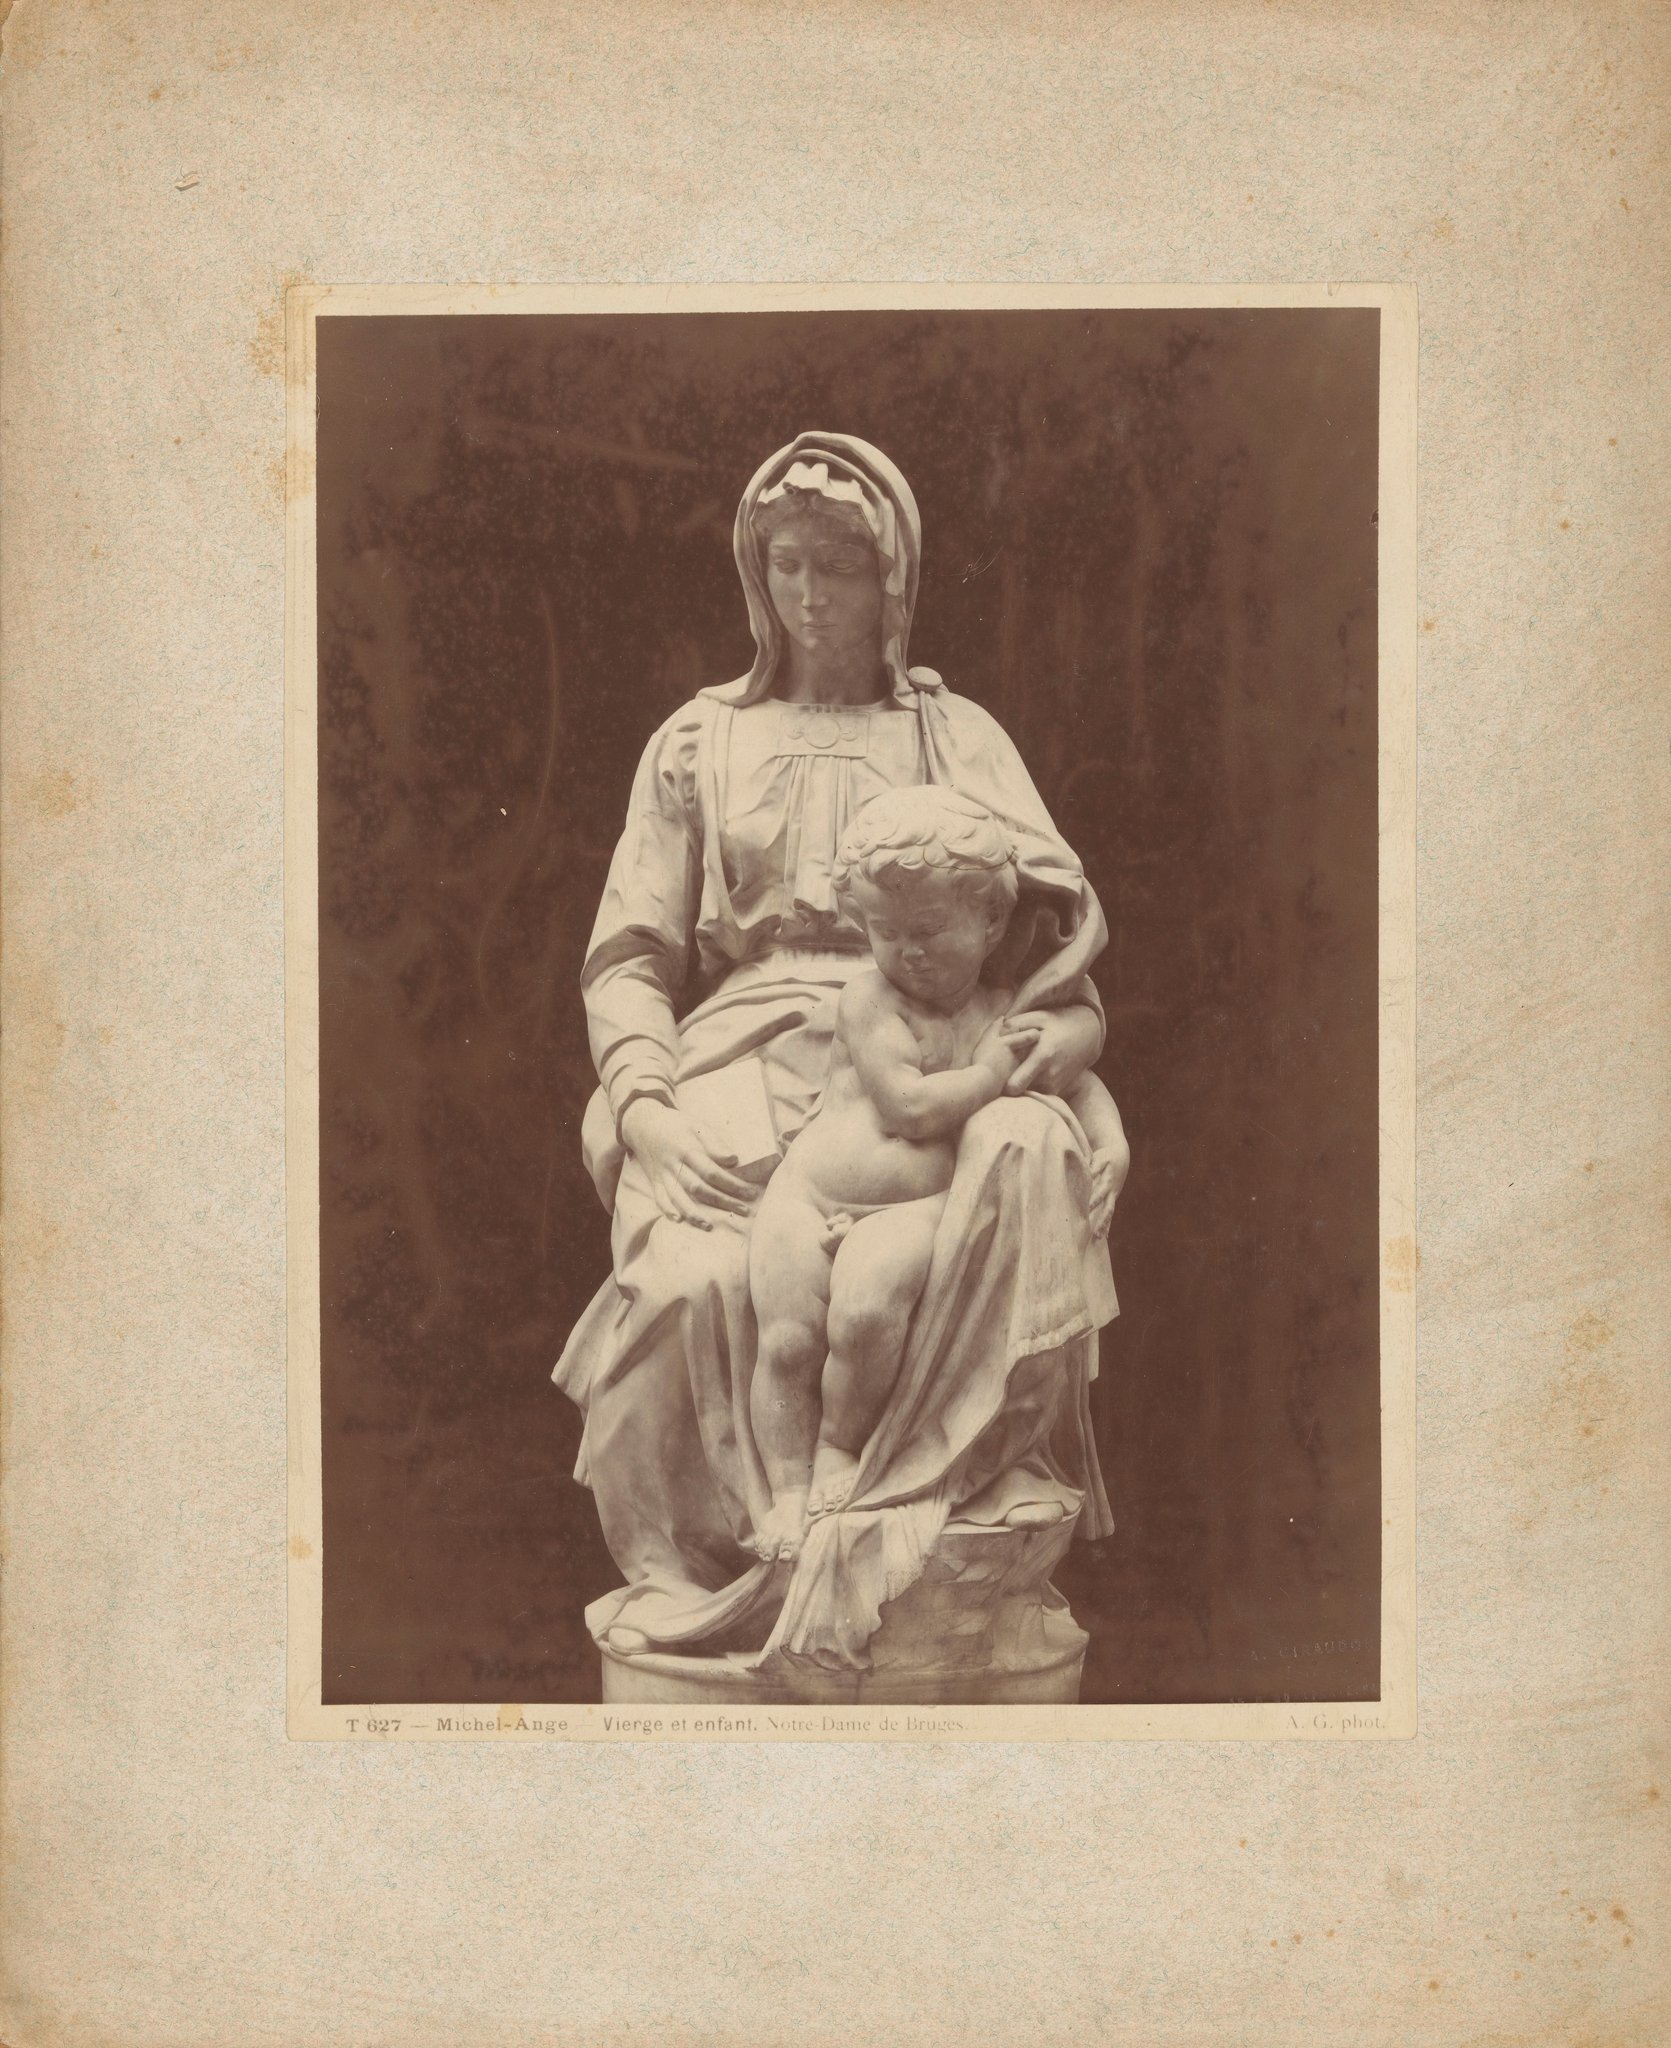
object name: photograph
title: Michel-Ange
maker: adolphe giraudon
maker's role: publisher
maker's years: 1849-1929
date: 1850-1900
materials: cardboard, photographic support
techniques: albumen print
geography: bruges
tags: mary sitting or enthroned, the christ-child in front of her in her lap (or in front of her bosom)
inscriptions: collector's mark: ‘Rijks normaalschool voor teekenonderwijzers Amsterdam’, inscription: ‘Notre-Dame de Bruges. A.G. phot.’, workshop stamp: ‘A. Giraudon/ Éditeur/ 15. R. Bonaparte. Paris’, number: ‘T 627’